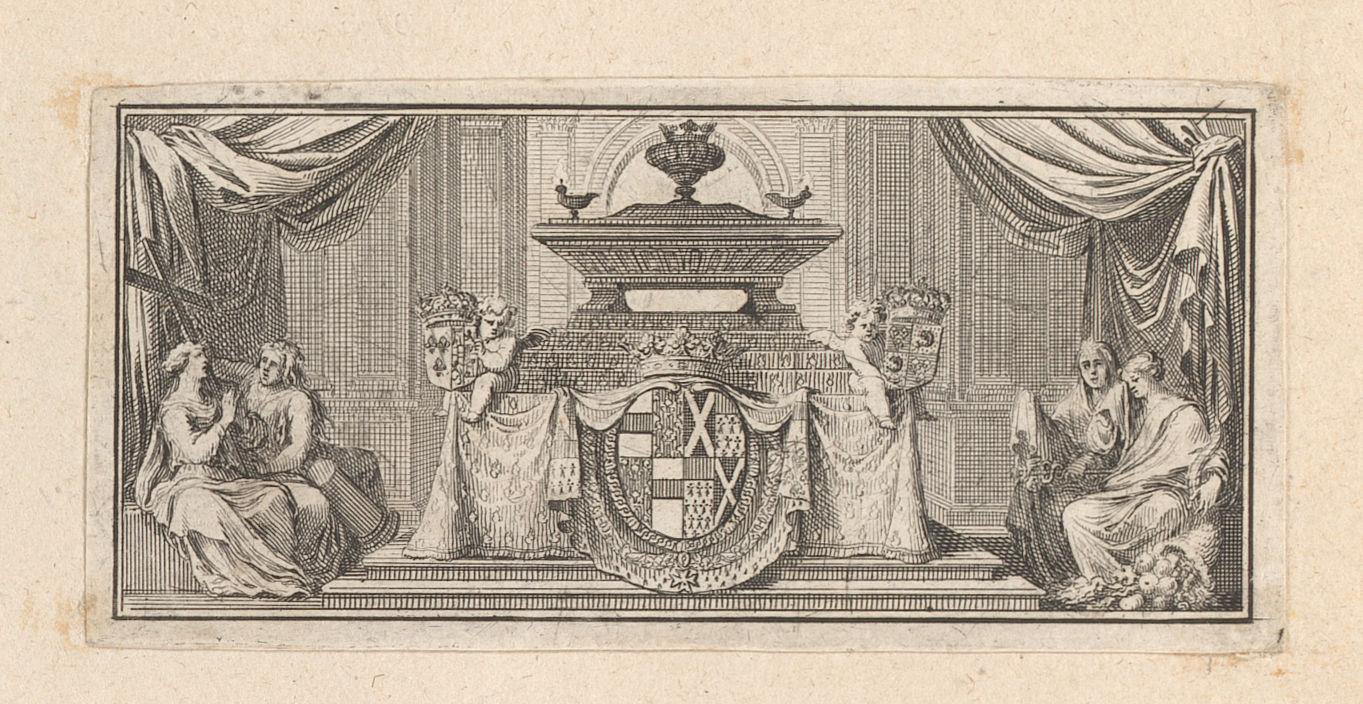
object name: print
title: Vignet met gezicht op een grafmonument in een kapel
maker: sébastien leclerc (i)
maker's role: print maker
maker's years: 1637-1714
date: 1679-1714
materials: paper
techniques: etching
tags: grave-building, monumental tomb, vignette, parts of church interior: chapel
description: IFF 17e siècle meldt dat volgens Jombert dit een vignet betreft uit: 'Oraison funebre d'Anne-Geneviefve de Bourbon (...)'. Het is onbekend door wie en wanneer dit werk werd gepubliceerd, maar Anne Geneviève de Bourbon stierf in 1679.